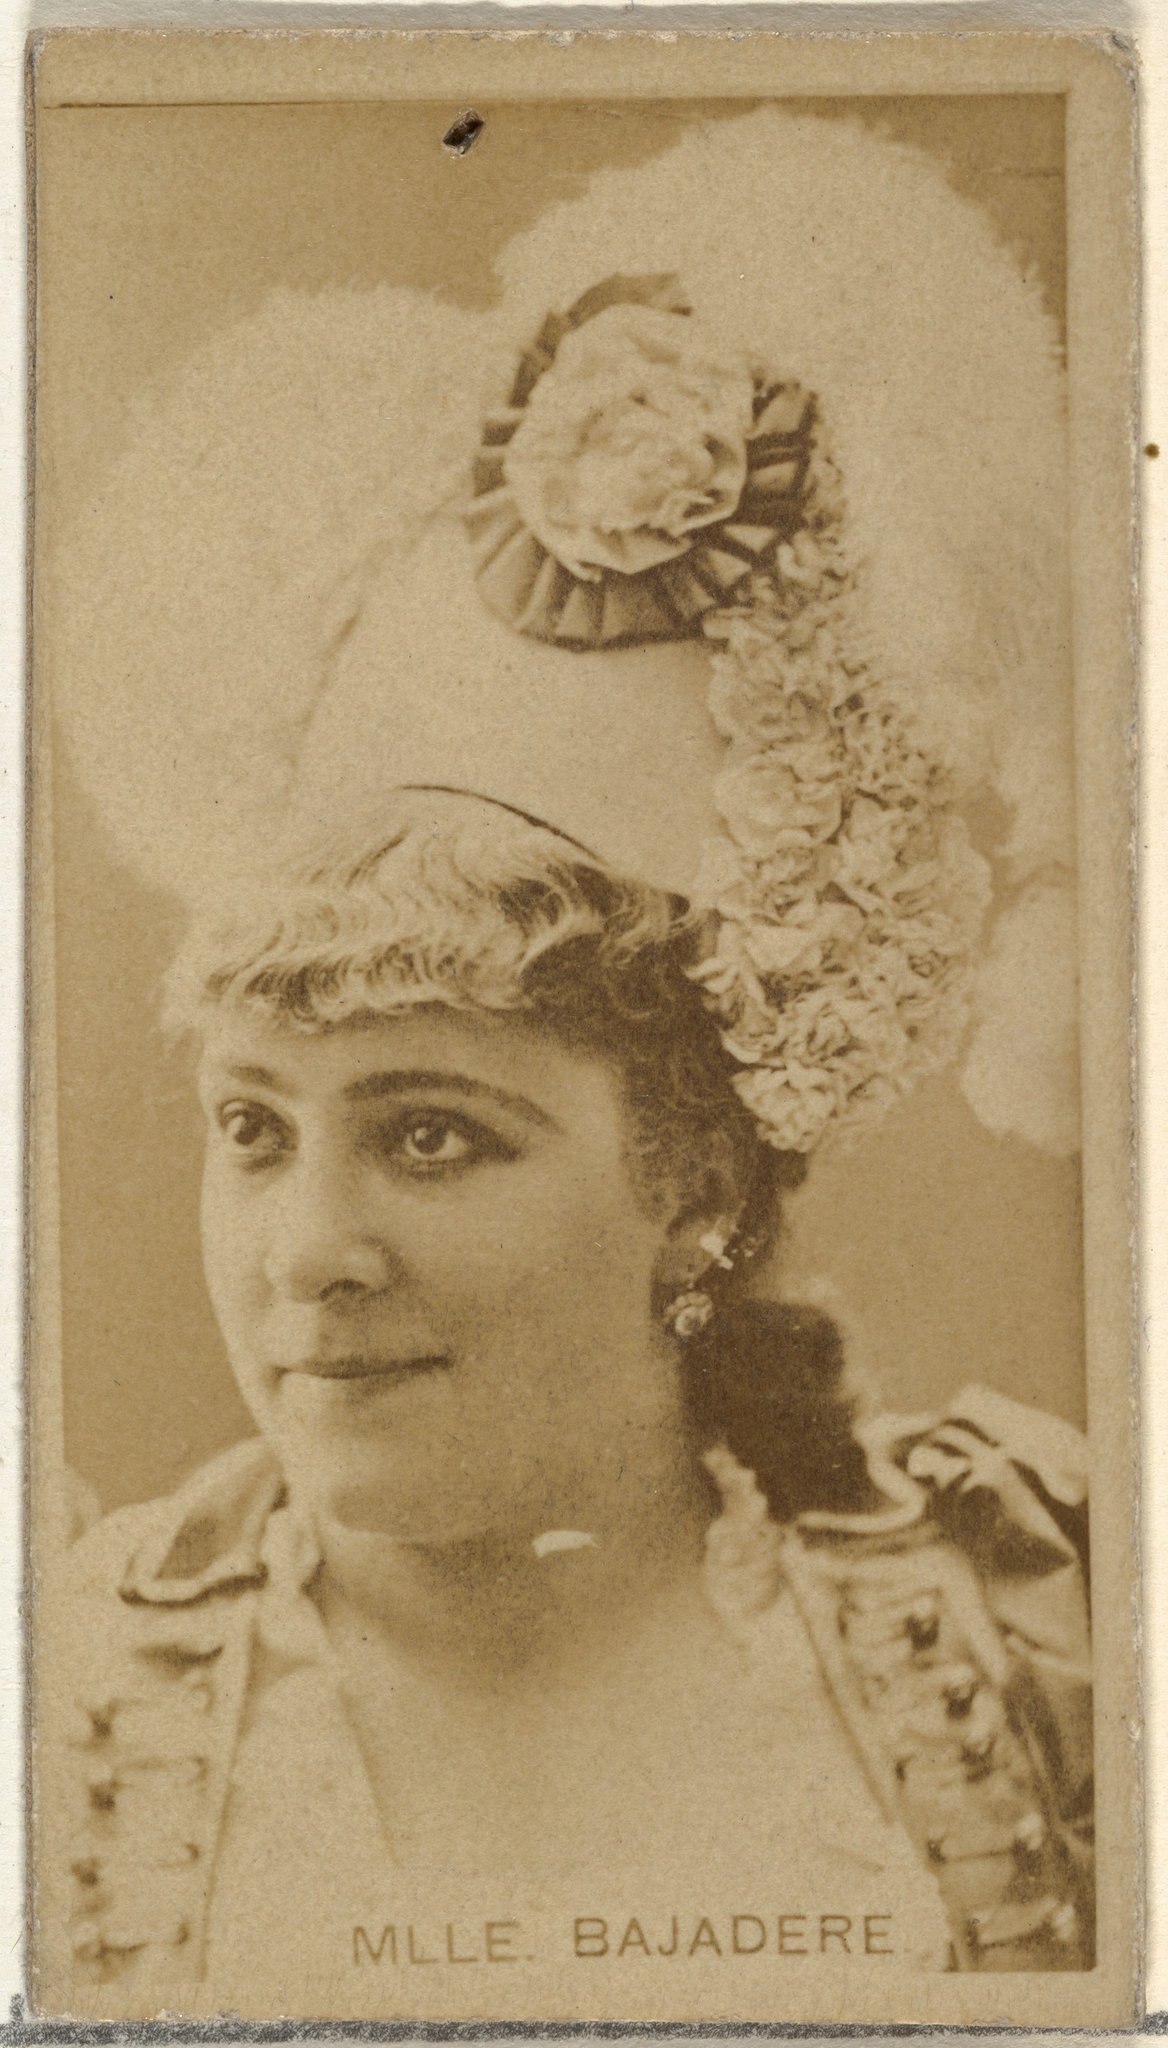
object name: photograph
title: Mlle. Bajadere, from the Actors and Actresses series (N145-8) issued by Duke Sons & Co. to promote Duke Cigarettes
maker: w. duke, sons & co.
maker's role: publisher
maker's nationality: american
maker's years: 1870-1920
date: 1891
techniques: albumen silver print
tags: portraits,women,actresses